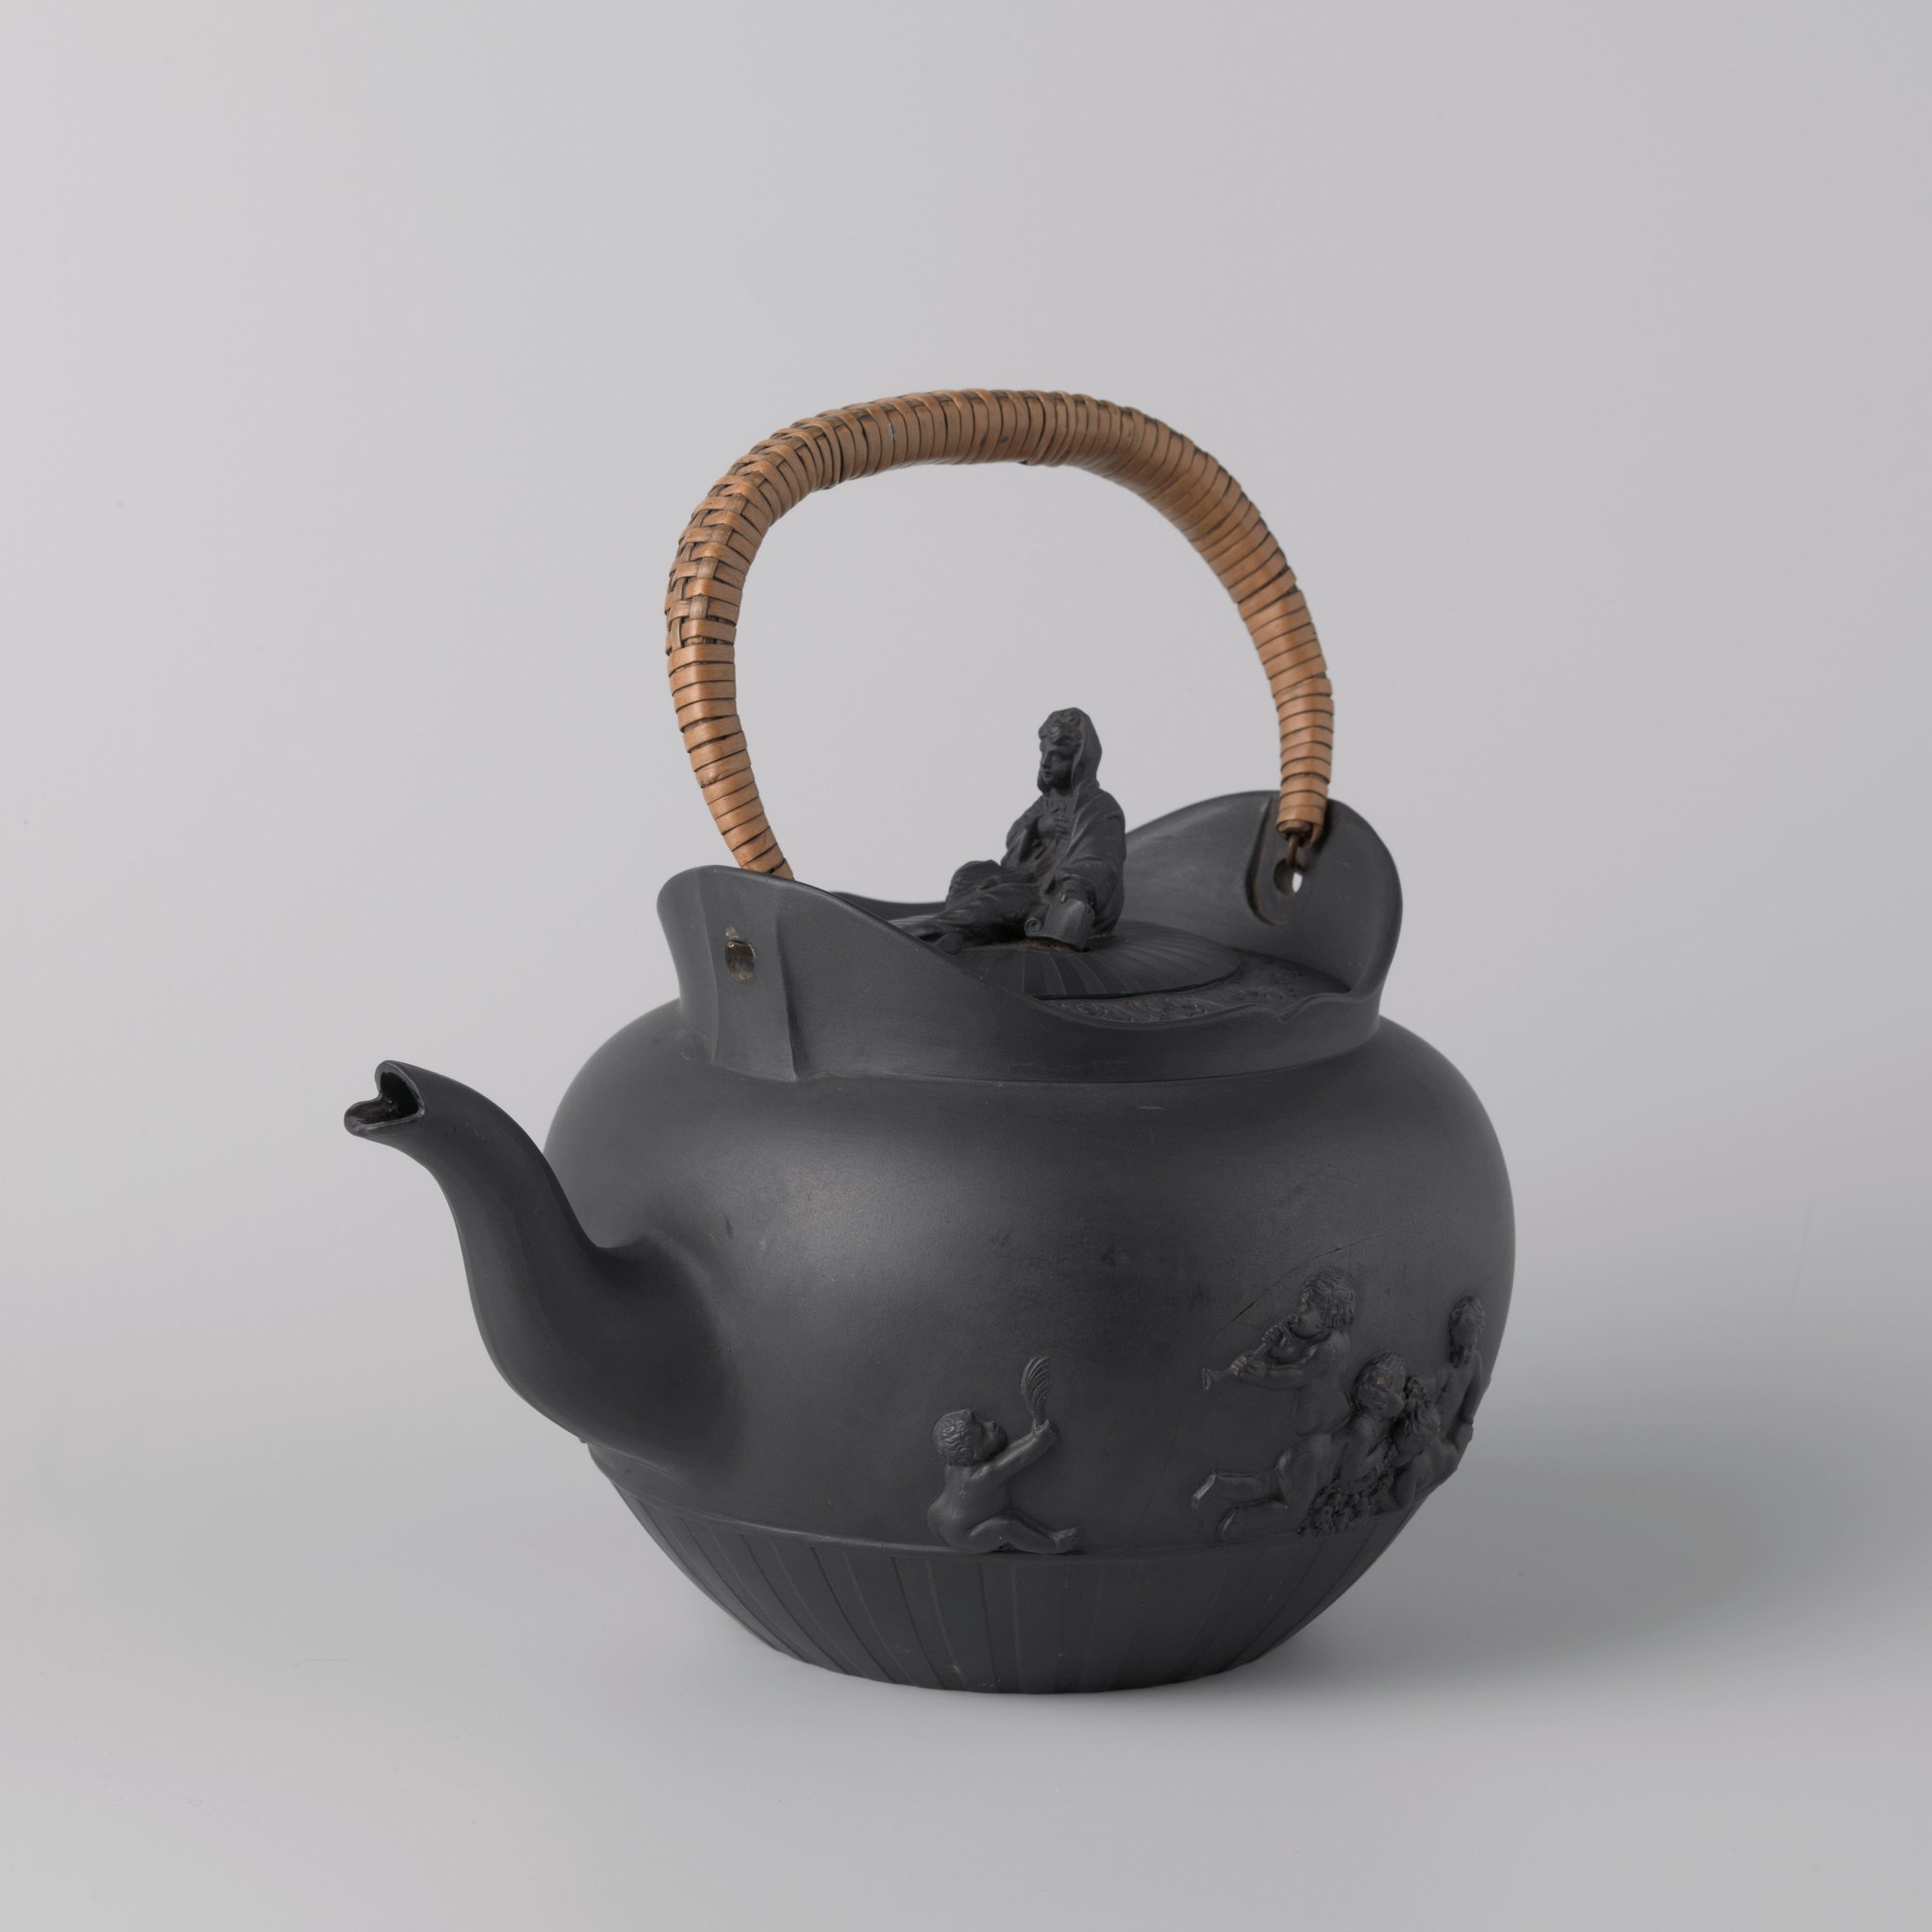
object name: chocoladeketel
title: Deksel van aardewerk, Wedgwood Black Basalt.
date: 1785-1800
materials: earthenware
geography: england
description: Het deksel heeft een knop in de vorm van een zittende vrouw met in haar linker hand een stuk papier.